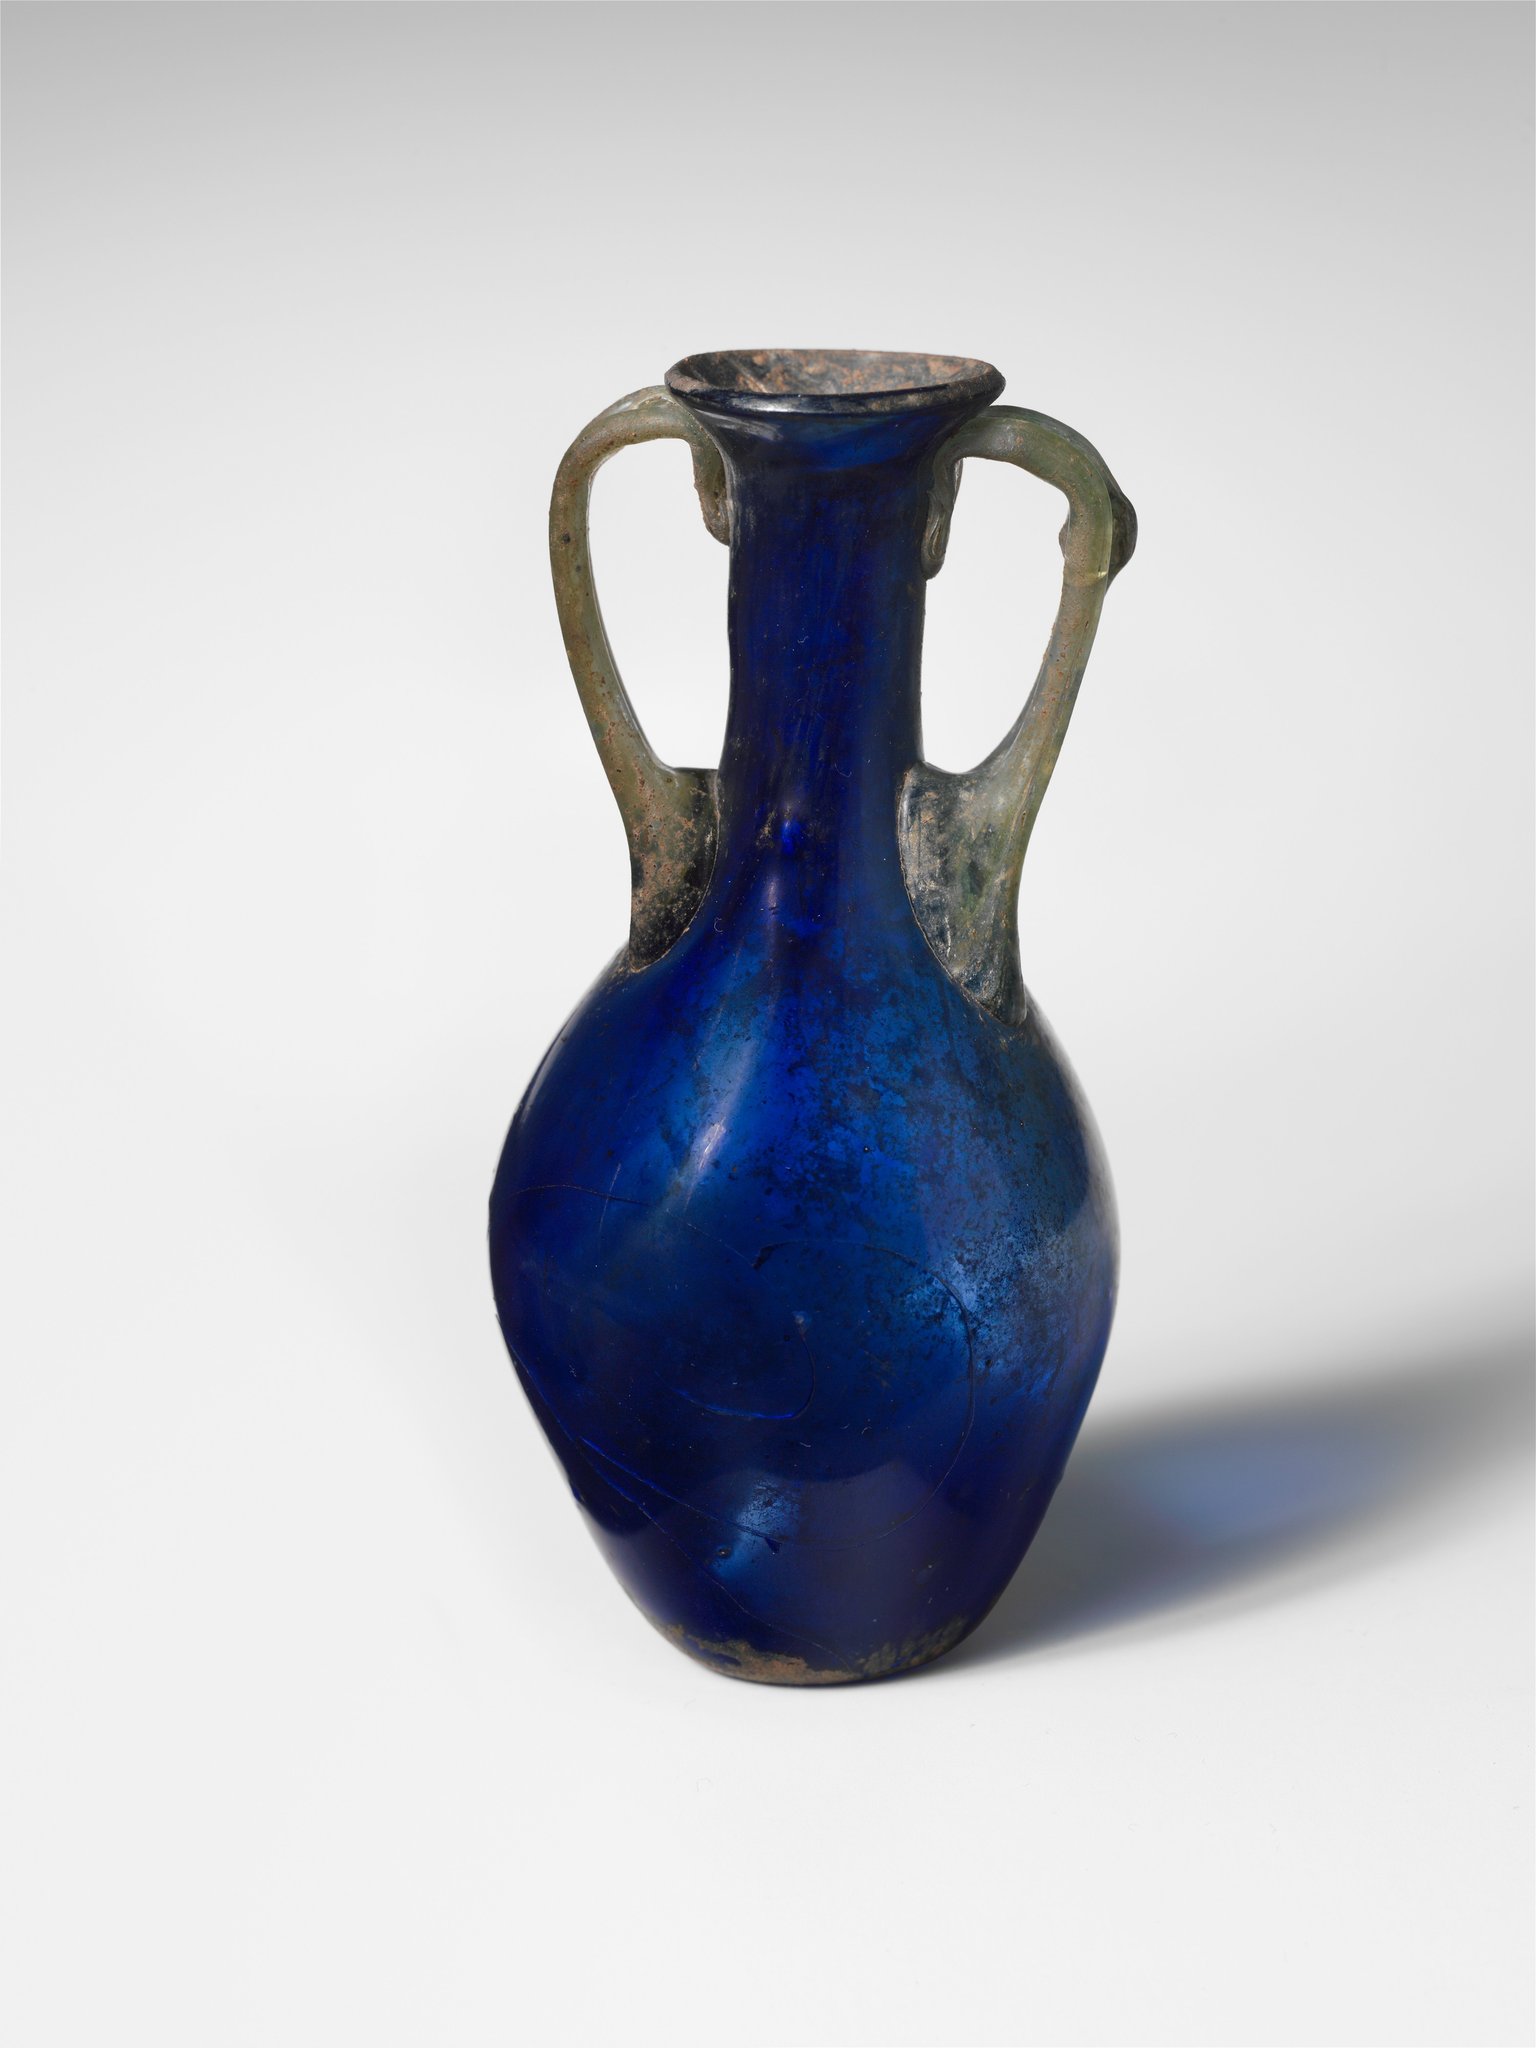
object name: amphoriskos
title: Glass two-handled bottle (amphoriskos)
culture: roman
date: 1-100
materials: glass